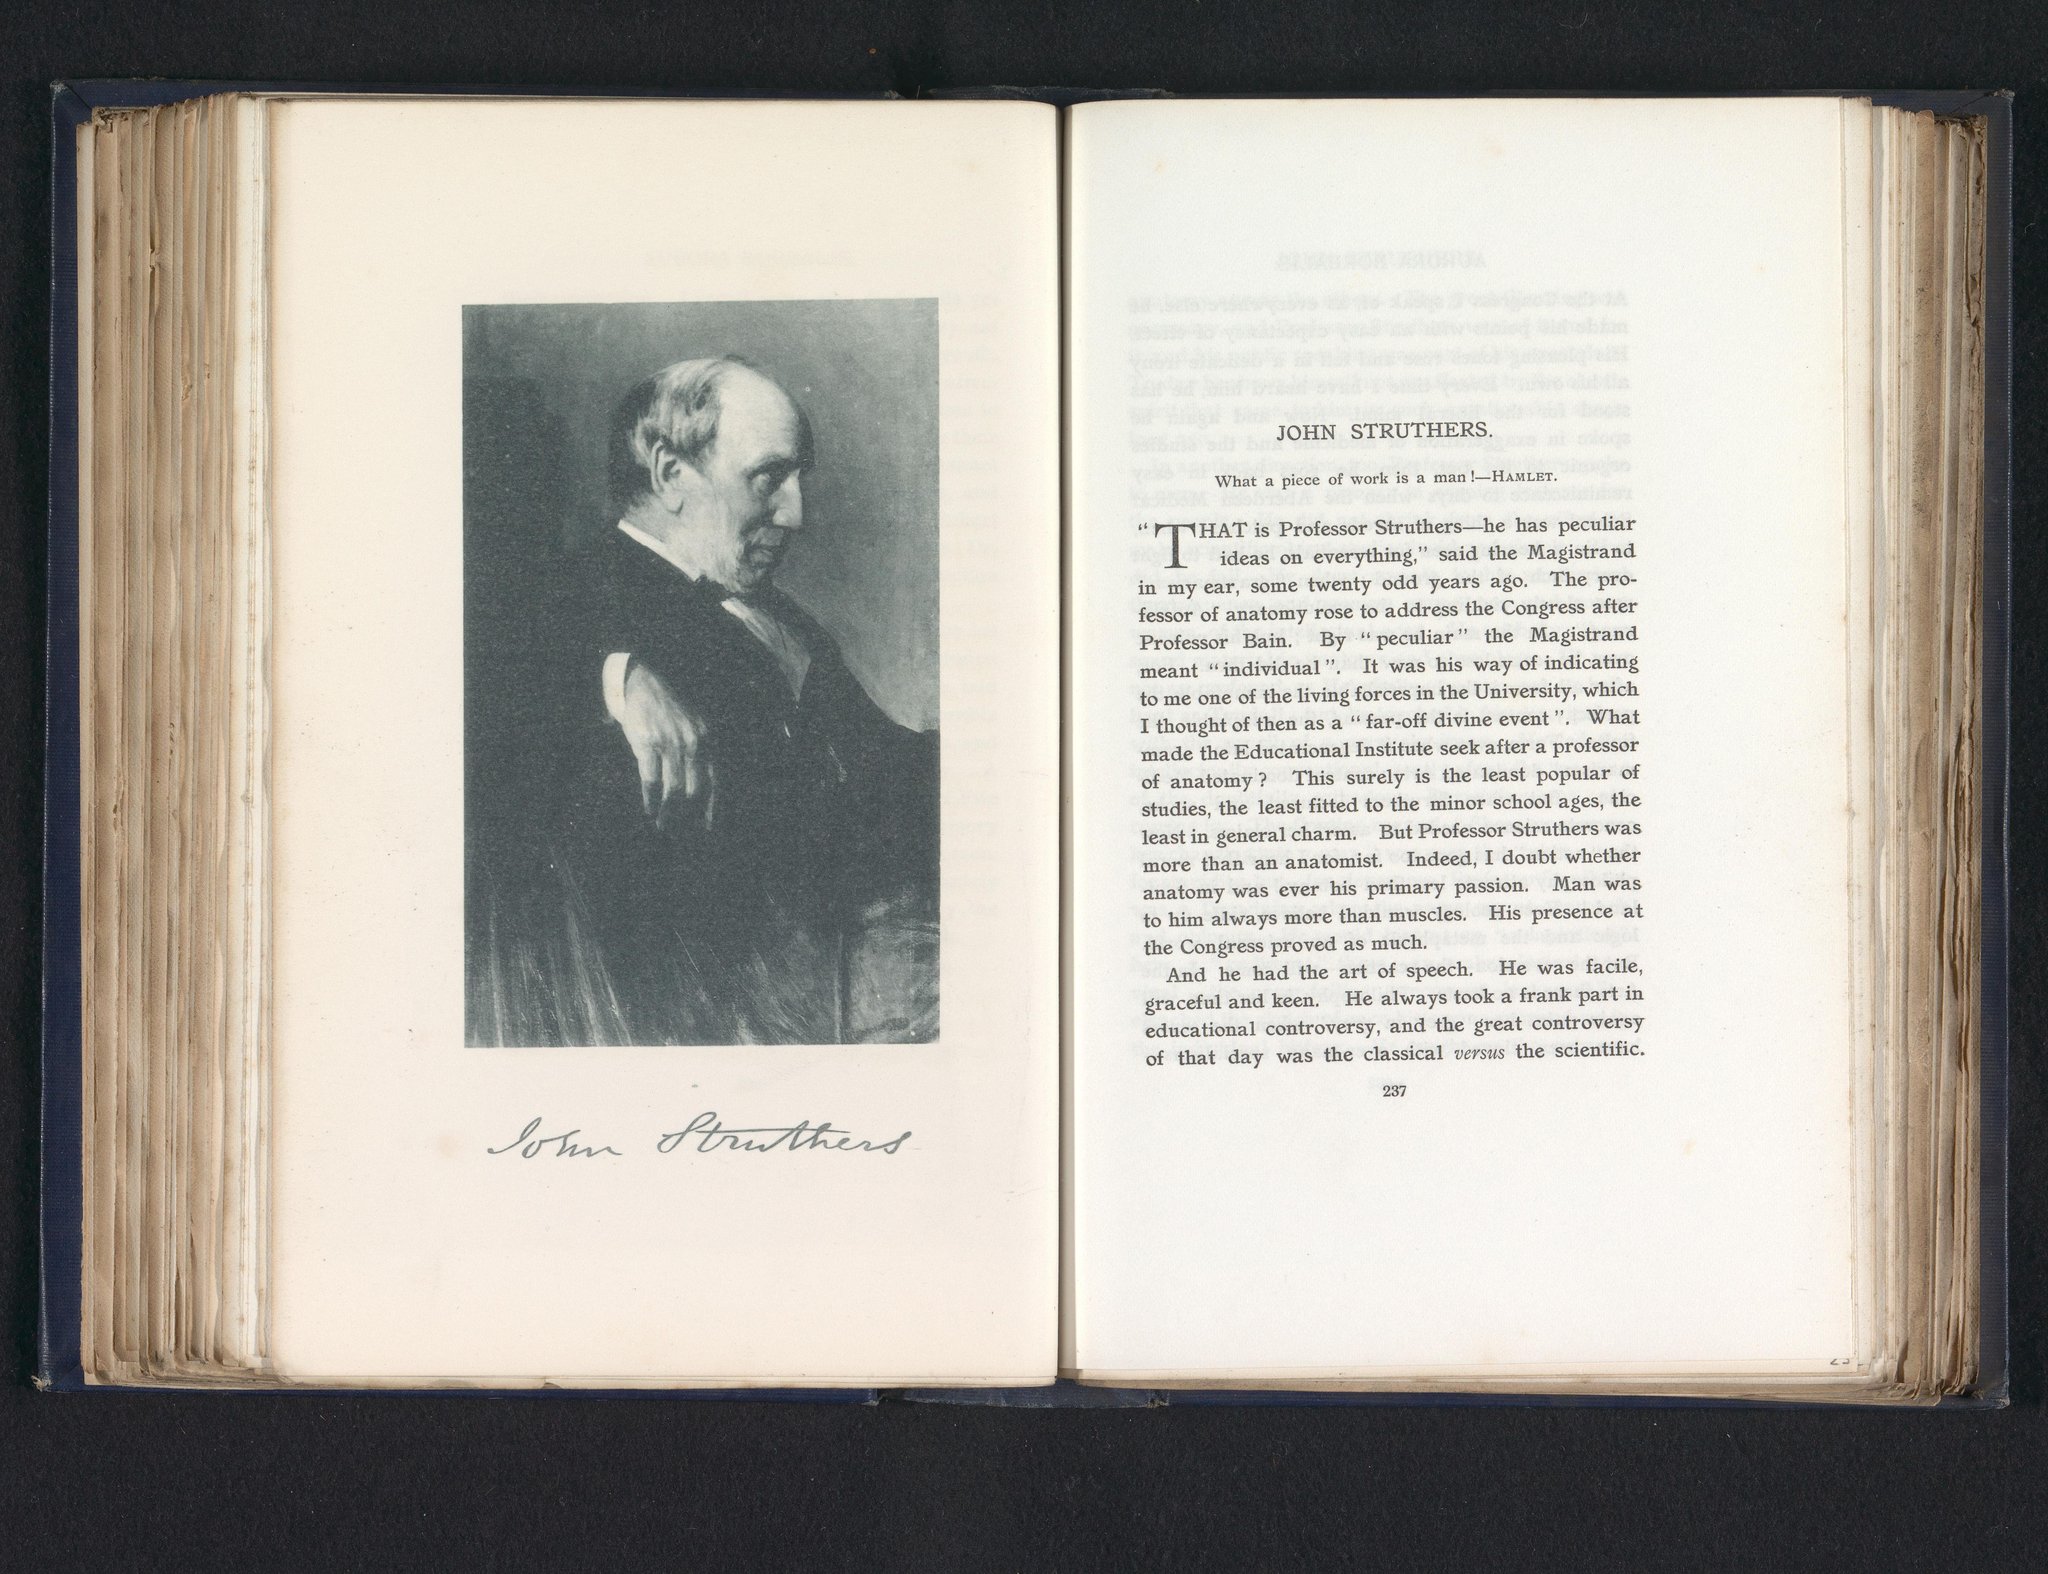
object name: page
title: Fotoreproductie van een portret van John Struthers door George Reid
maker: Anonymous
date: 1889-1899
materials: paper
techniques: photograph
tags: scholar, philosopher